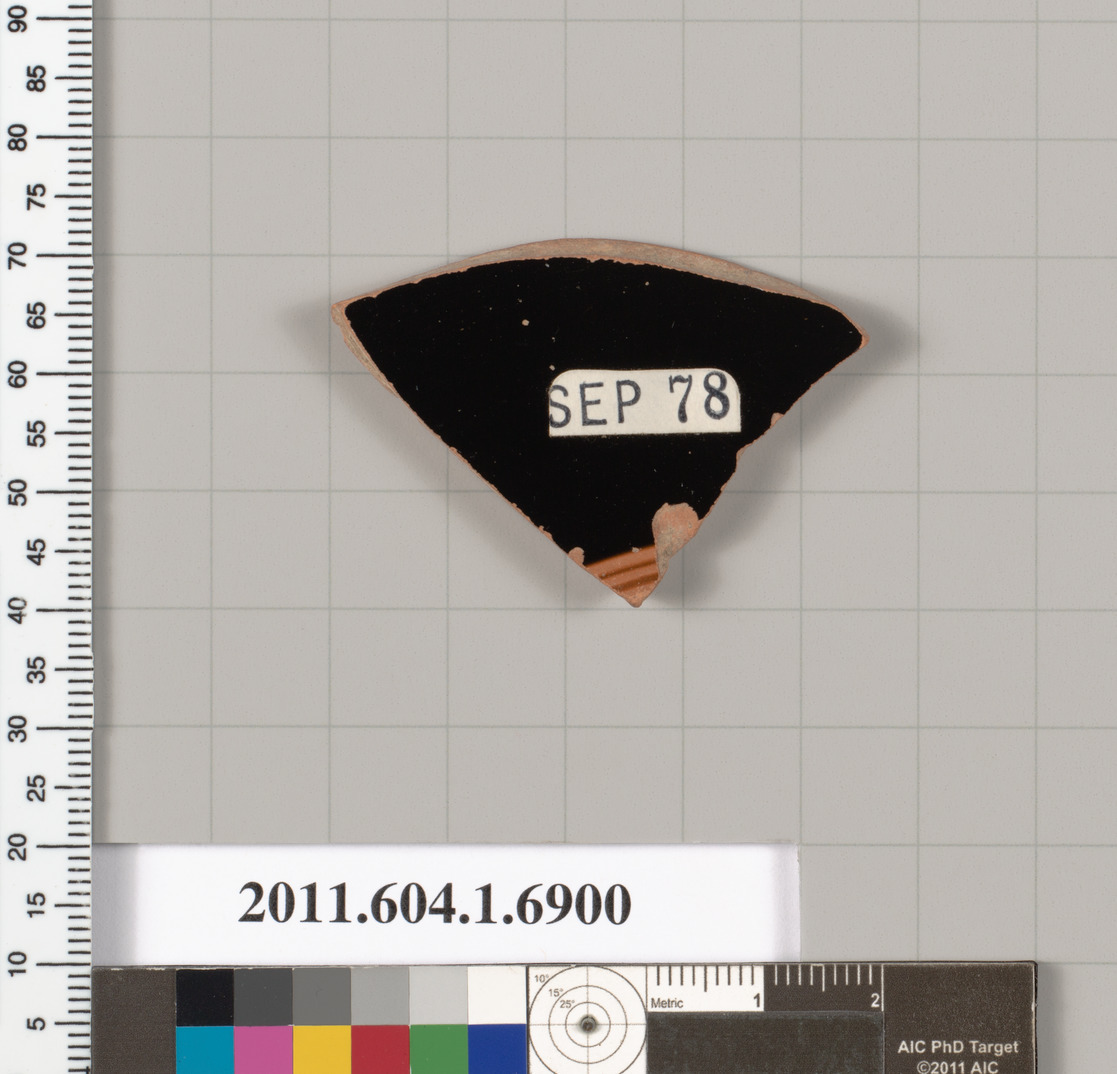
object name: kylix fragment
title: Terracotta fragment of a kylix (drinking cup)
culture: greek, attic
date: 490-470 BCE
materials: terracotta